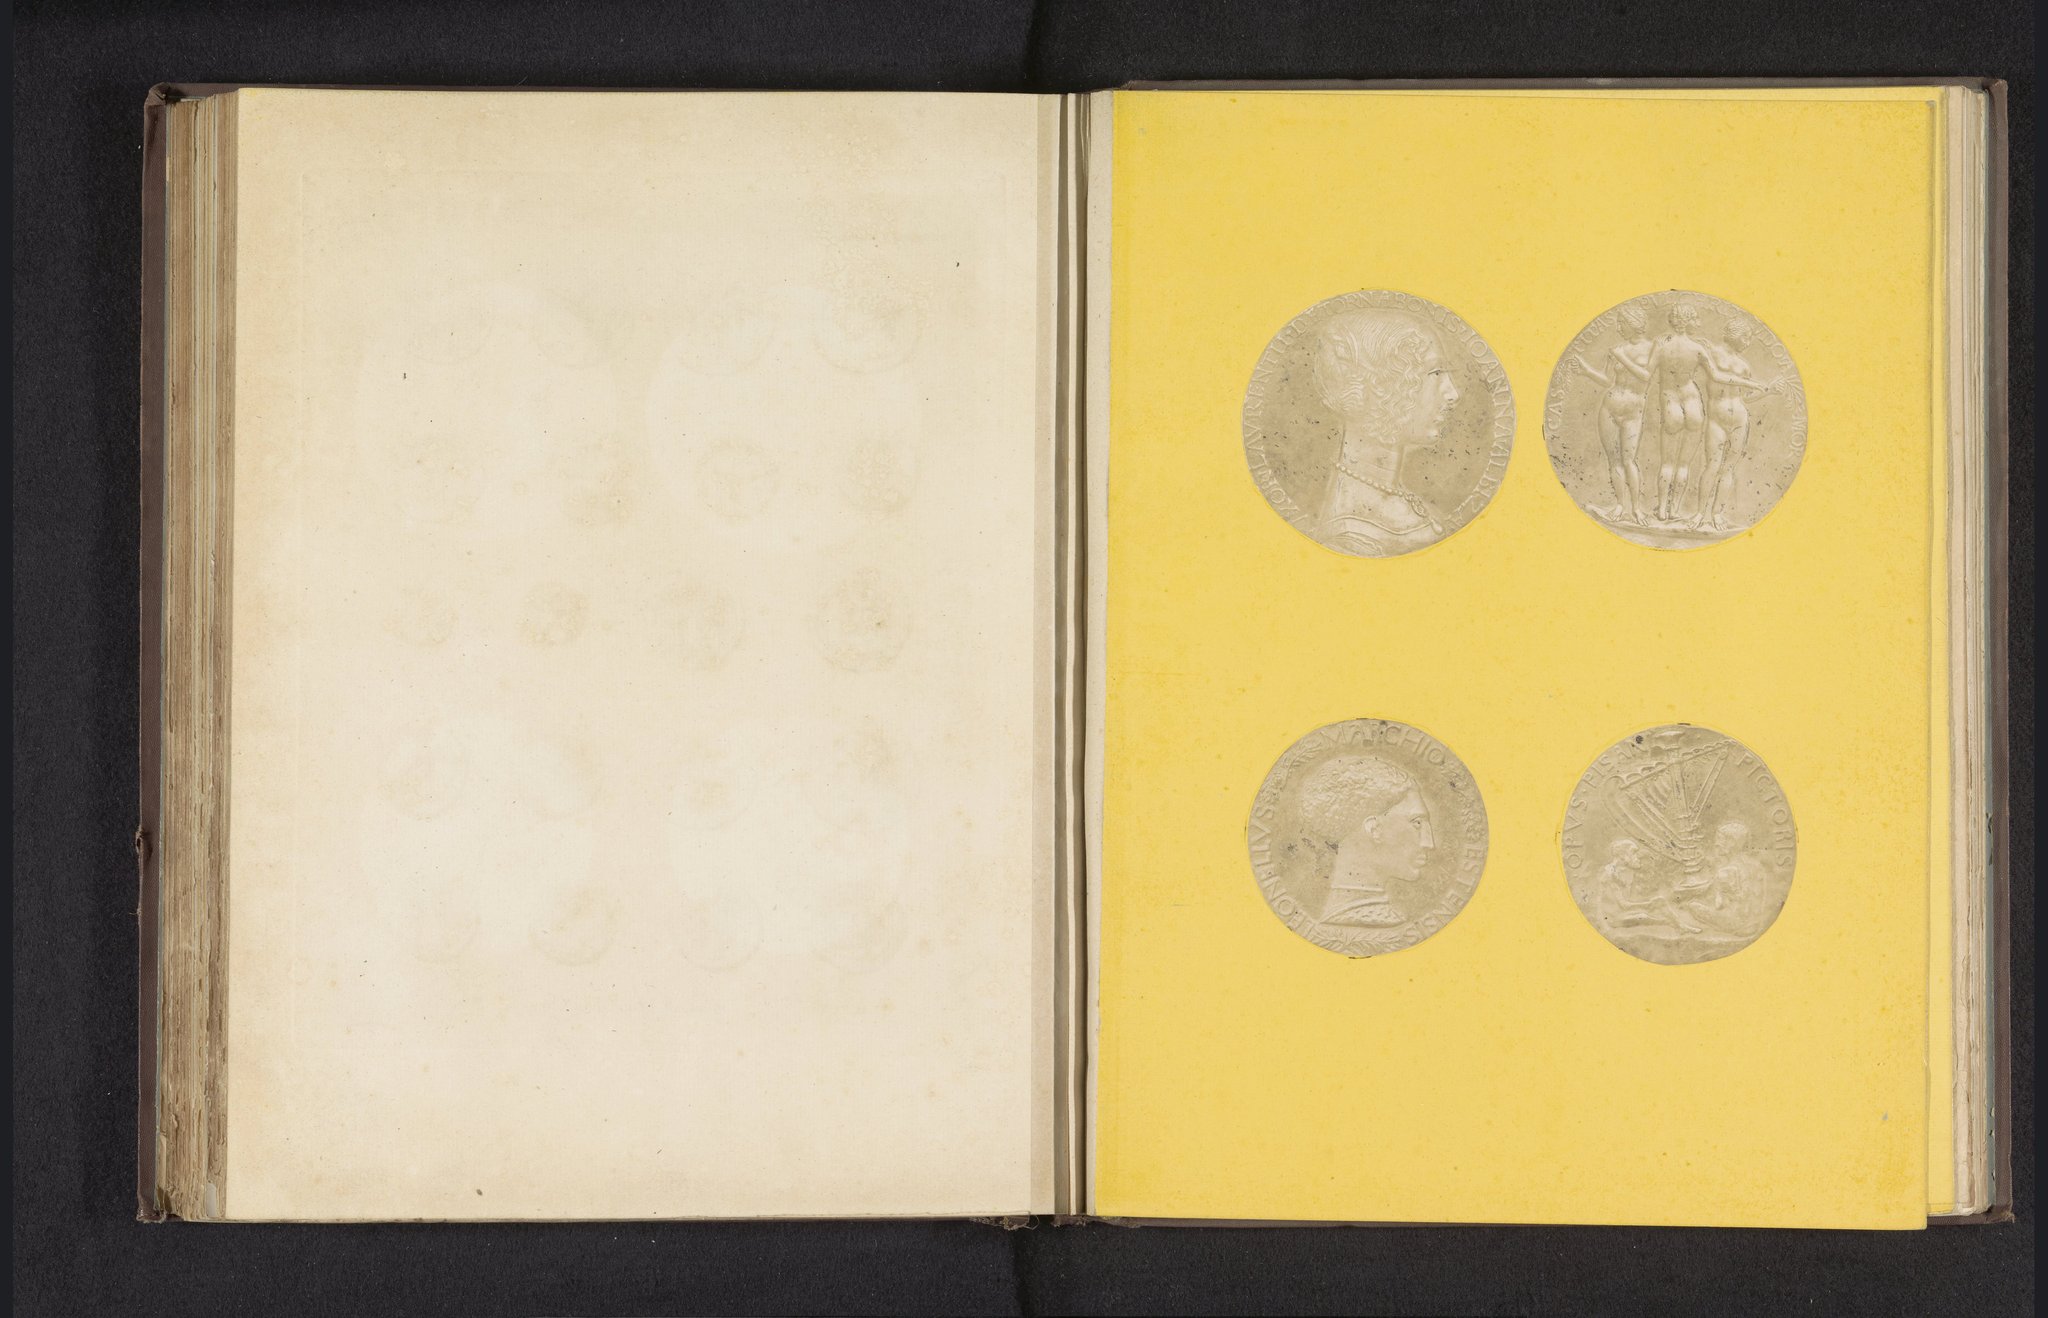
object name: photograph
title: Vier munten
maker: Anonymous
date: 1879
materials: photographic support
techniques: albumen print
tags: coin